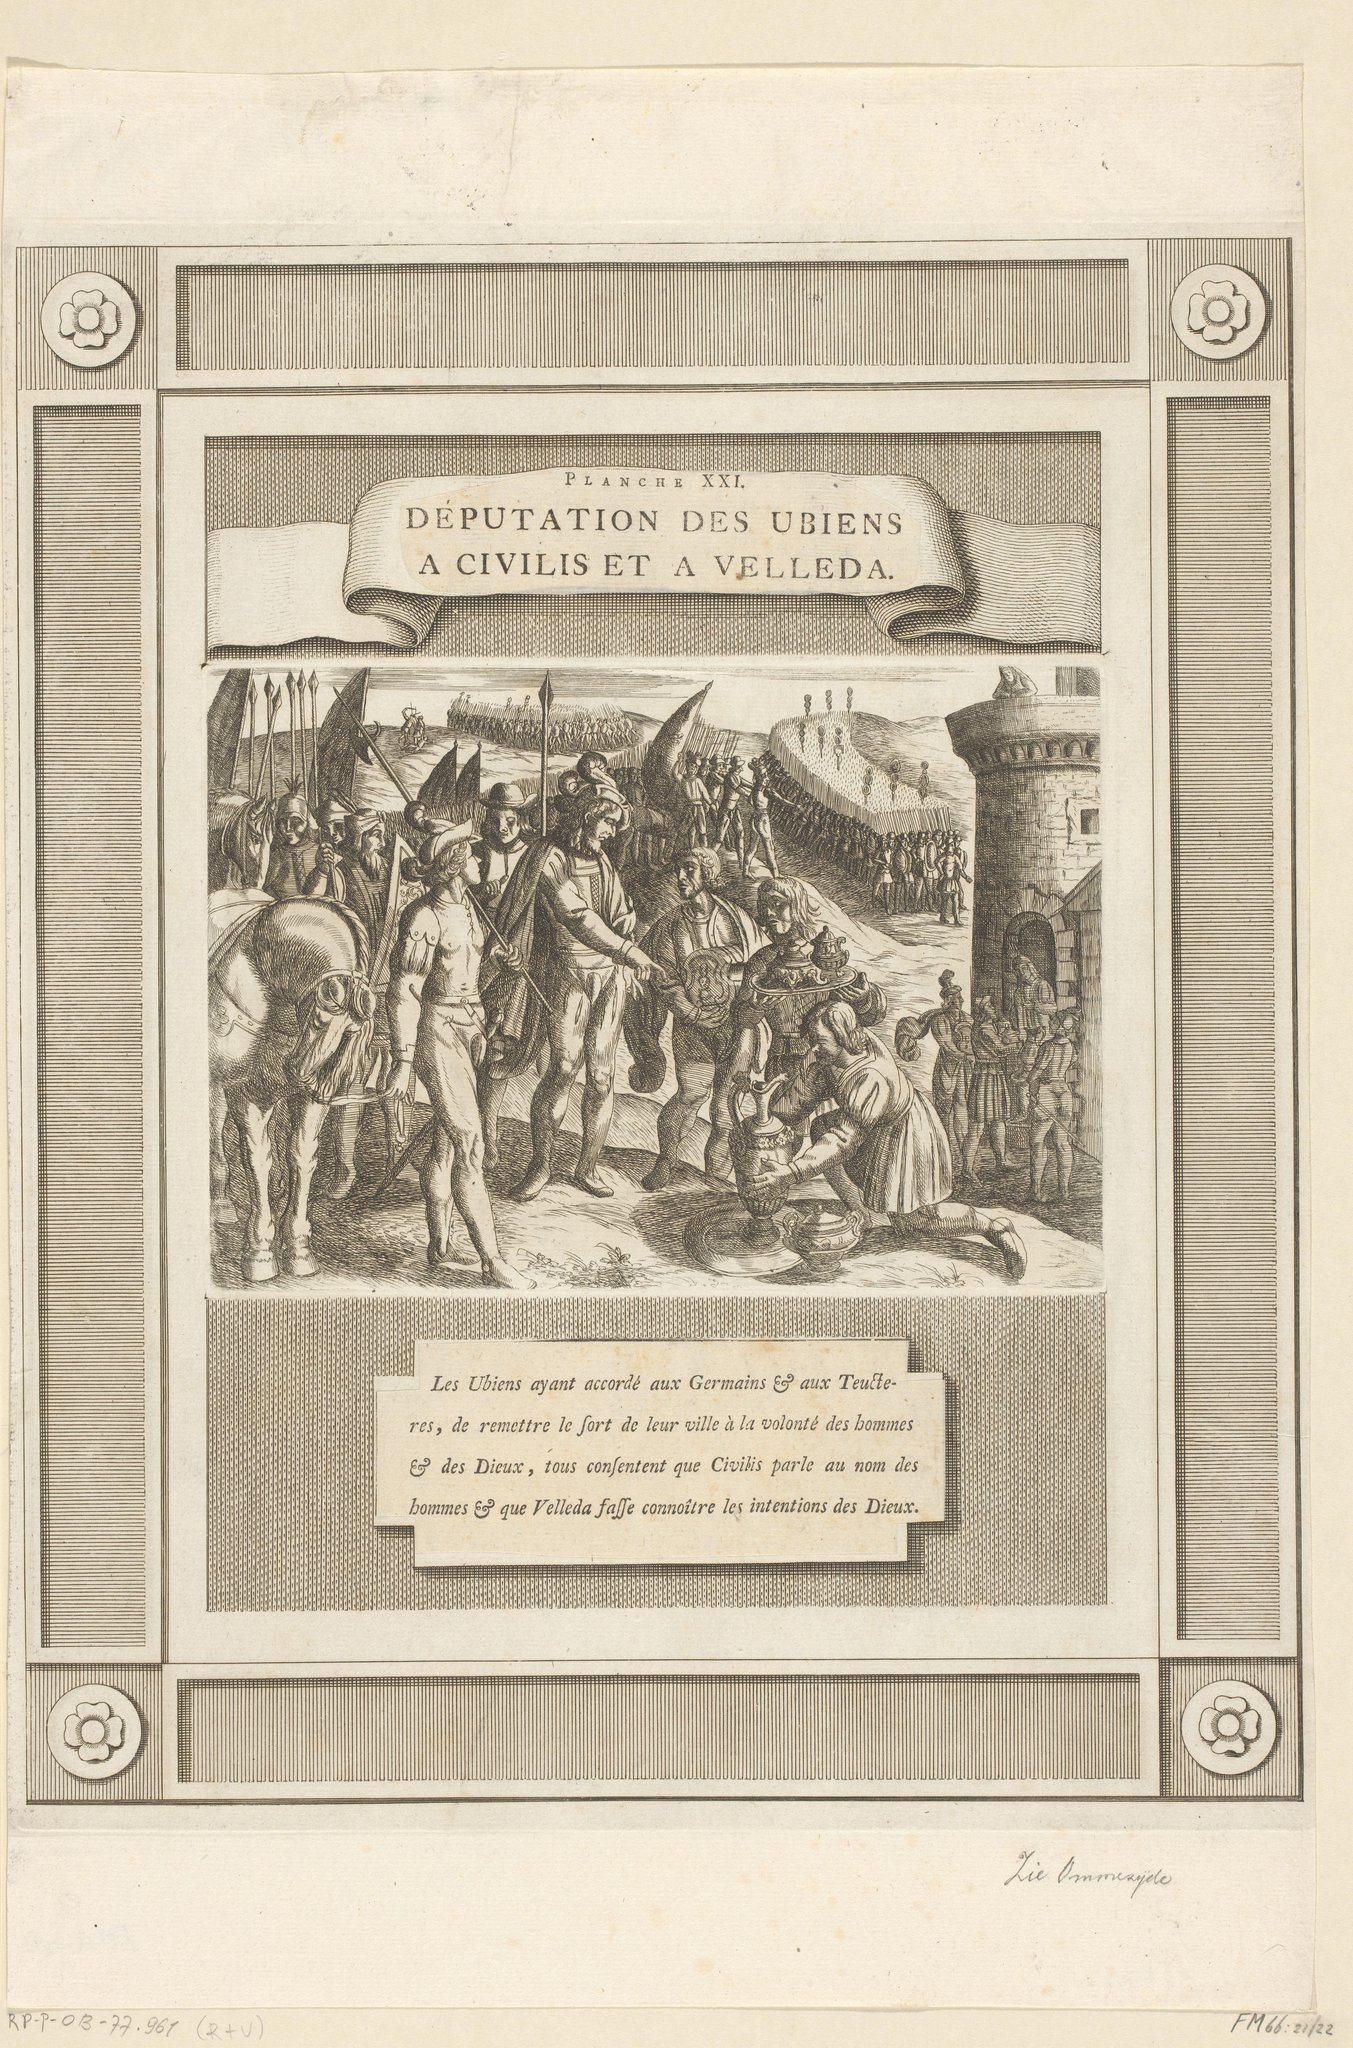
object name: history print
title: Députation des Ubiens a Civilis et a Velleda / planche XXI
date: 1768-1770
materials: paper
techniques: engraving, etching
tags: extinct, 'historical' peoples (with name), netherlands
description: Gezanten uit Keulen brengen Civilis geschenken. Prent 21 in een serie over de Bataafse Opstand, gekopieerd naar de reeks Batavorum cum Romanis bellum van Antonio Tempesta (Otto Vaenius, Antwerpen 1612). Illustratie voor: Marquis de St. Simon, Histoire de la guerre des Bataves et des Romains, d'après César; Corneille Tacite, Aux dépens de Marc-Michel Rey, Amsterdam 1770. Voorstellingen gedrukt in een grote ornamentele omlijsting waarin bovenaan een uitgeknipte titel en onderaan een onderschrift in het Frans is geplakt.